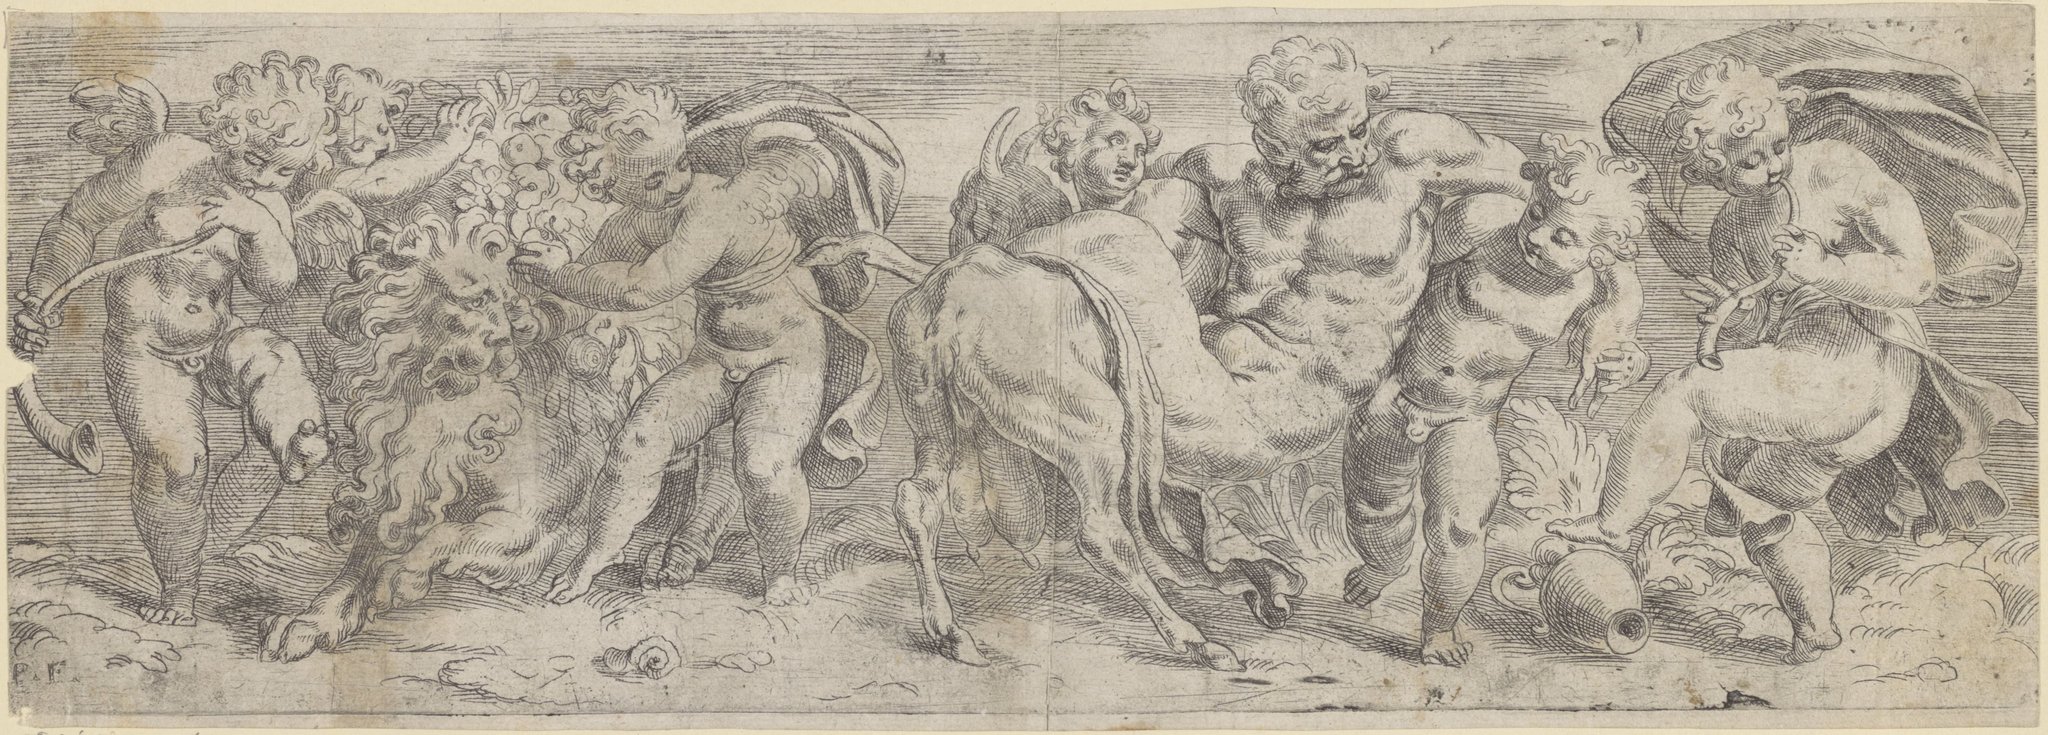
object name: print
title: Dronken sater en putti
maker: paolo farinati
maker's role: painter, print maker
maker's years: 1524-1606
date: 1534-1606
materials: paper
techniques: etching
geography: italy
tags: satyr(s) (in general), drunkenness, cupids: 'amores', 'amoretti', 'putti'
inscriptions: collector's mark: Lugt 240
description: Twee putti helpen een dronken sater van zijn geit af te stijgen. Rechts een putto met een blaasinstrument. Links drie putti bij een leeuw.